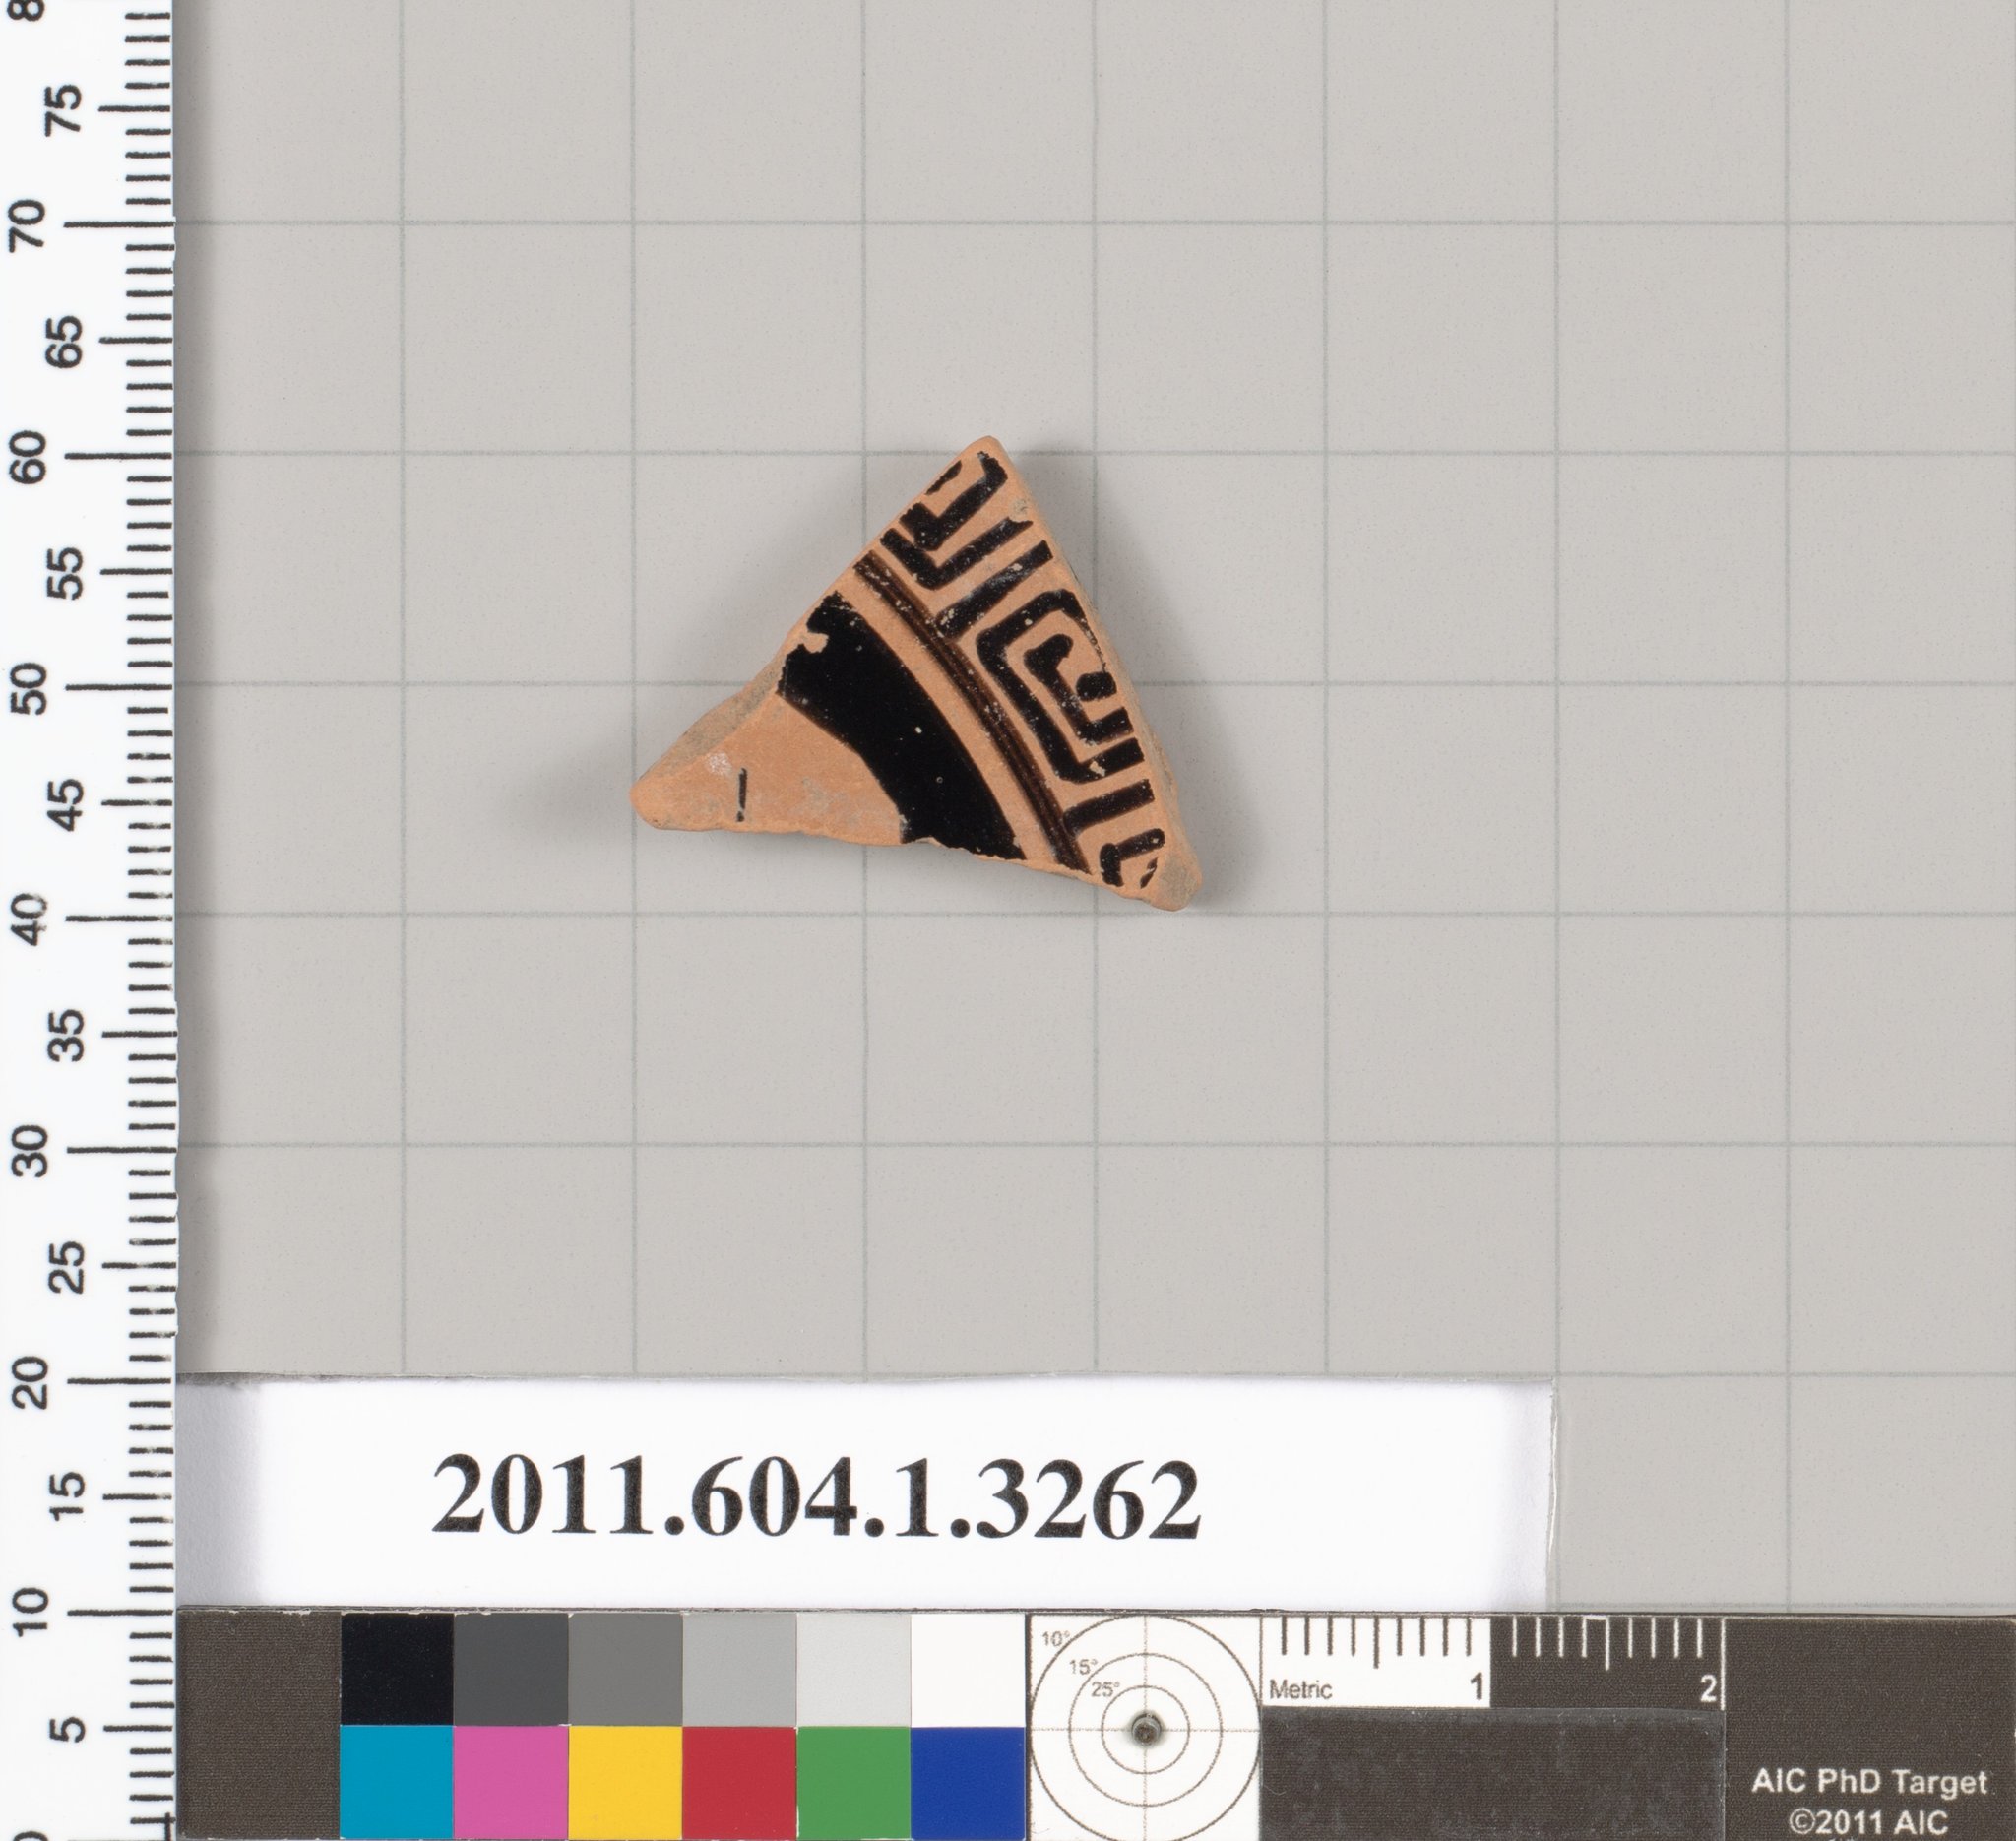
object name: kylix fragment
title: Terracotta fragment of a kylix (drinking cup)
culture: greek, attic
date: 490-480 BCE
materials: terracotta